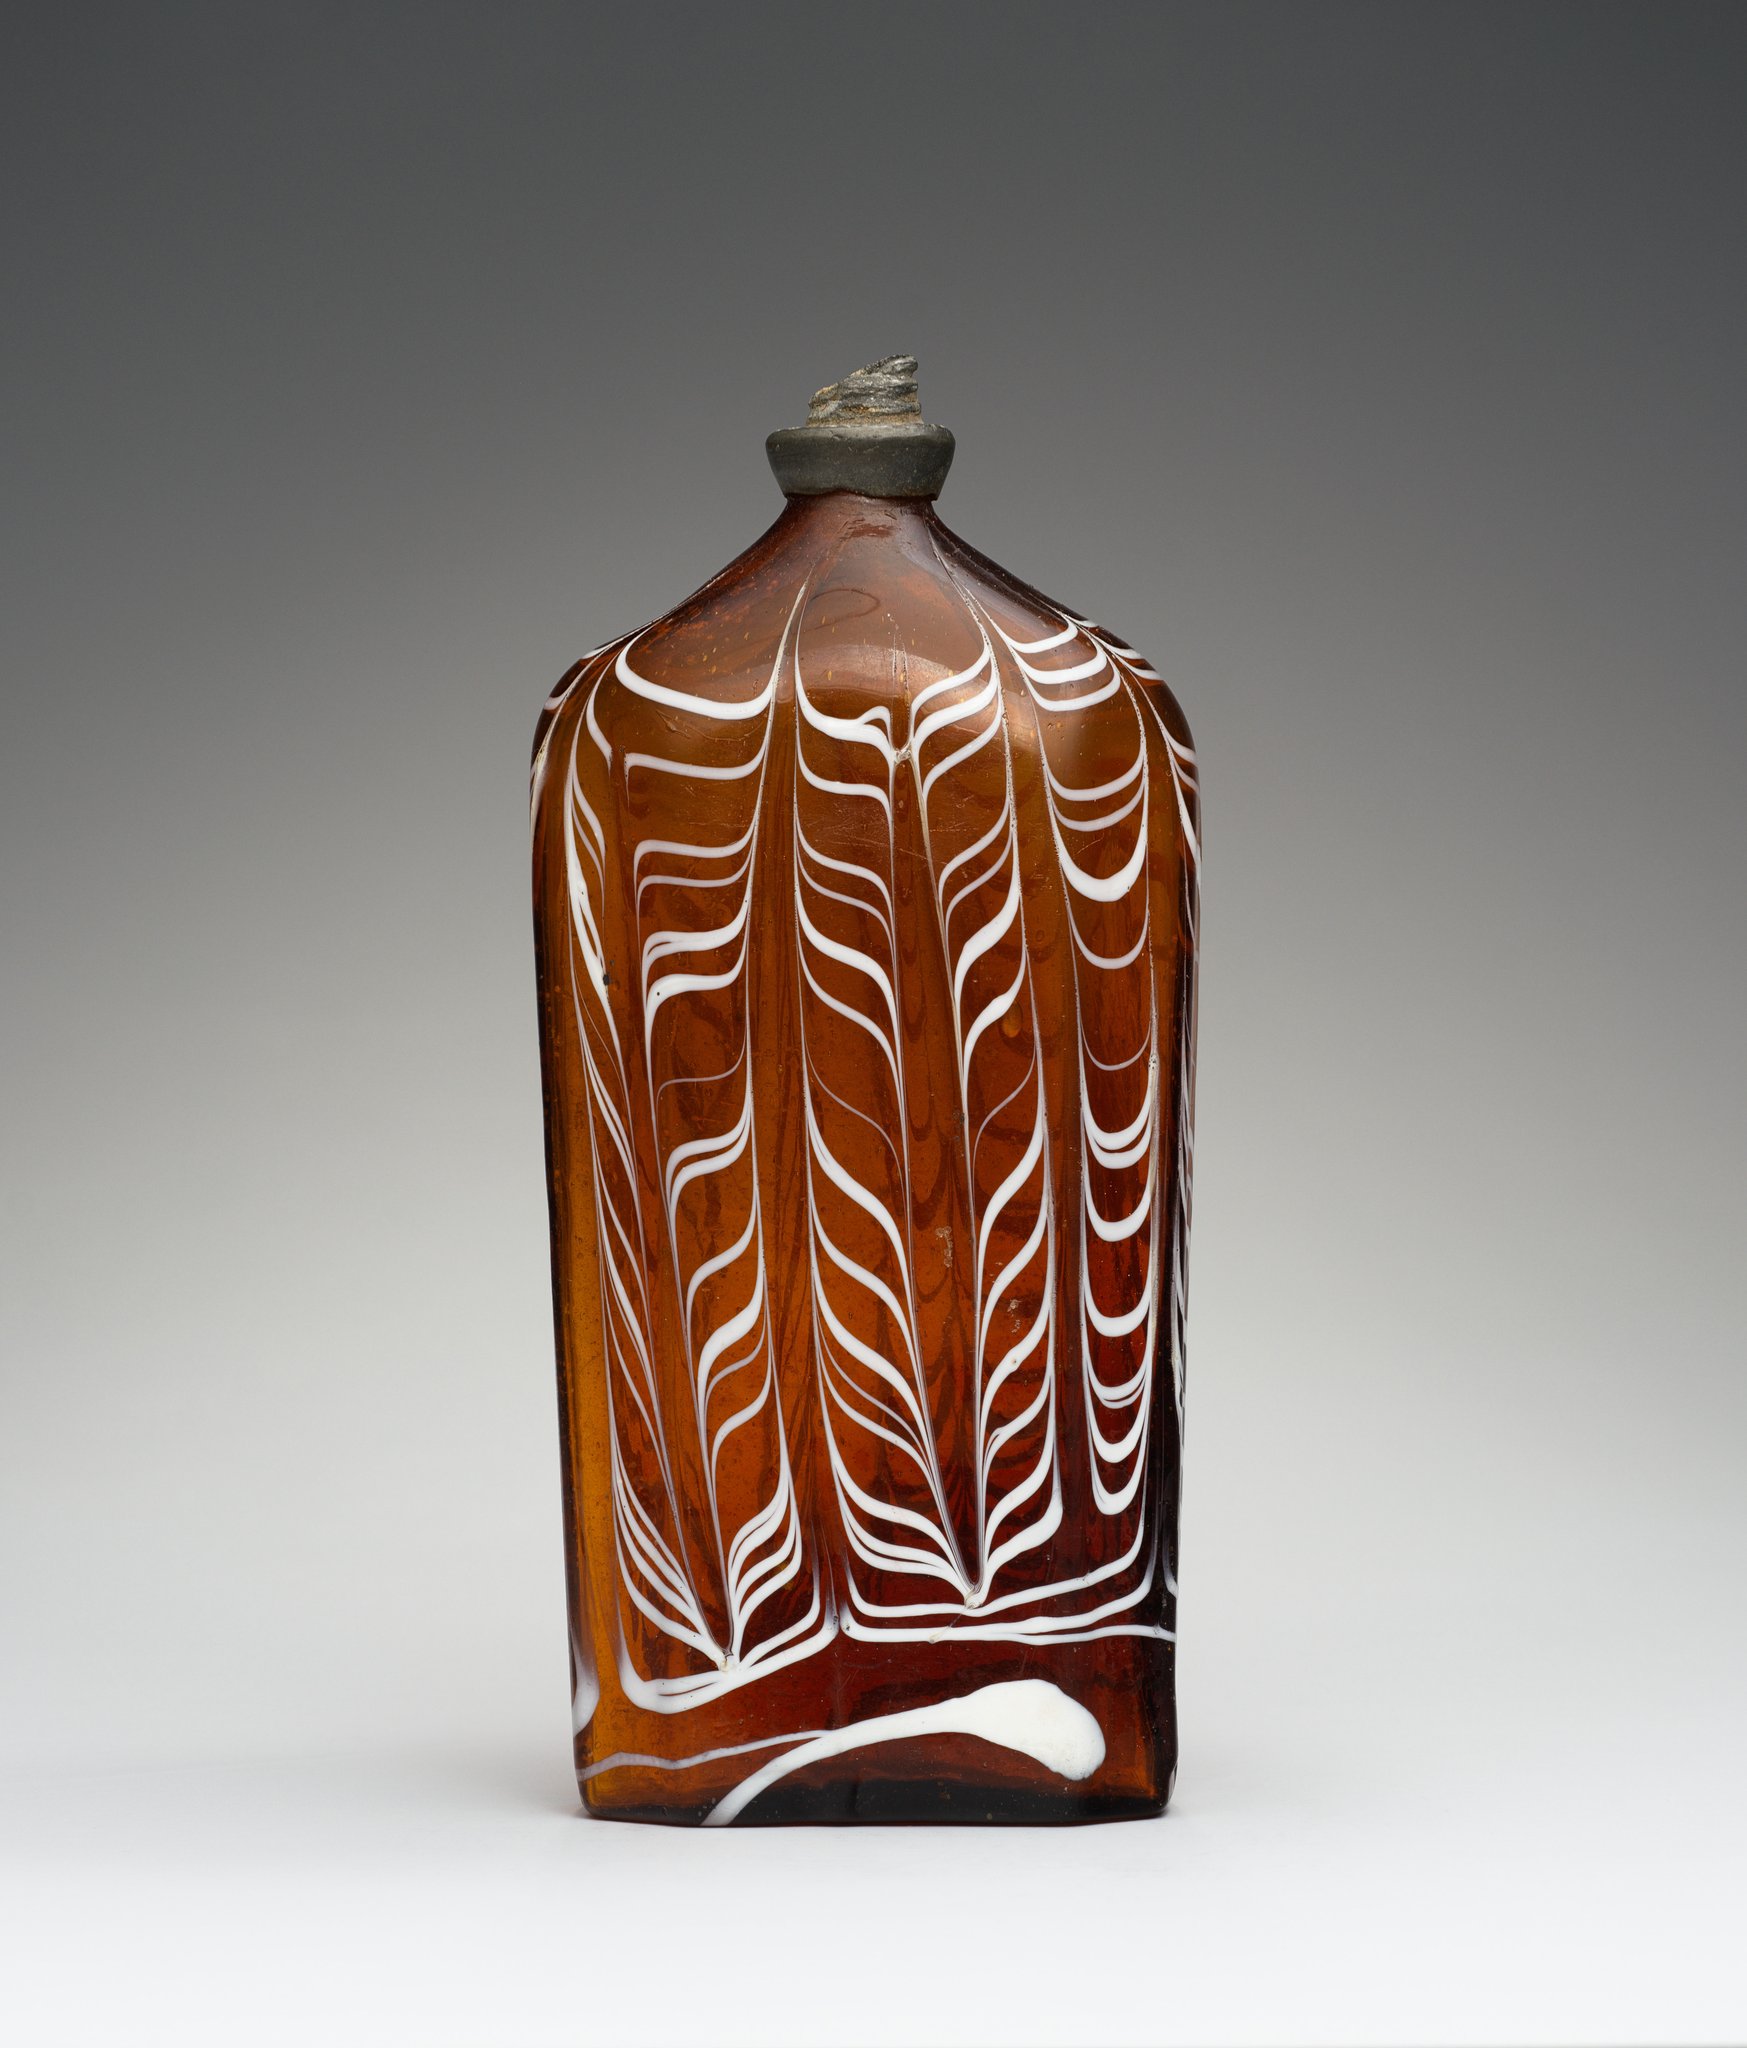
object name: bottle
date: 1701-1800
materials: glass, pewter